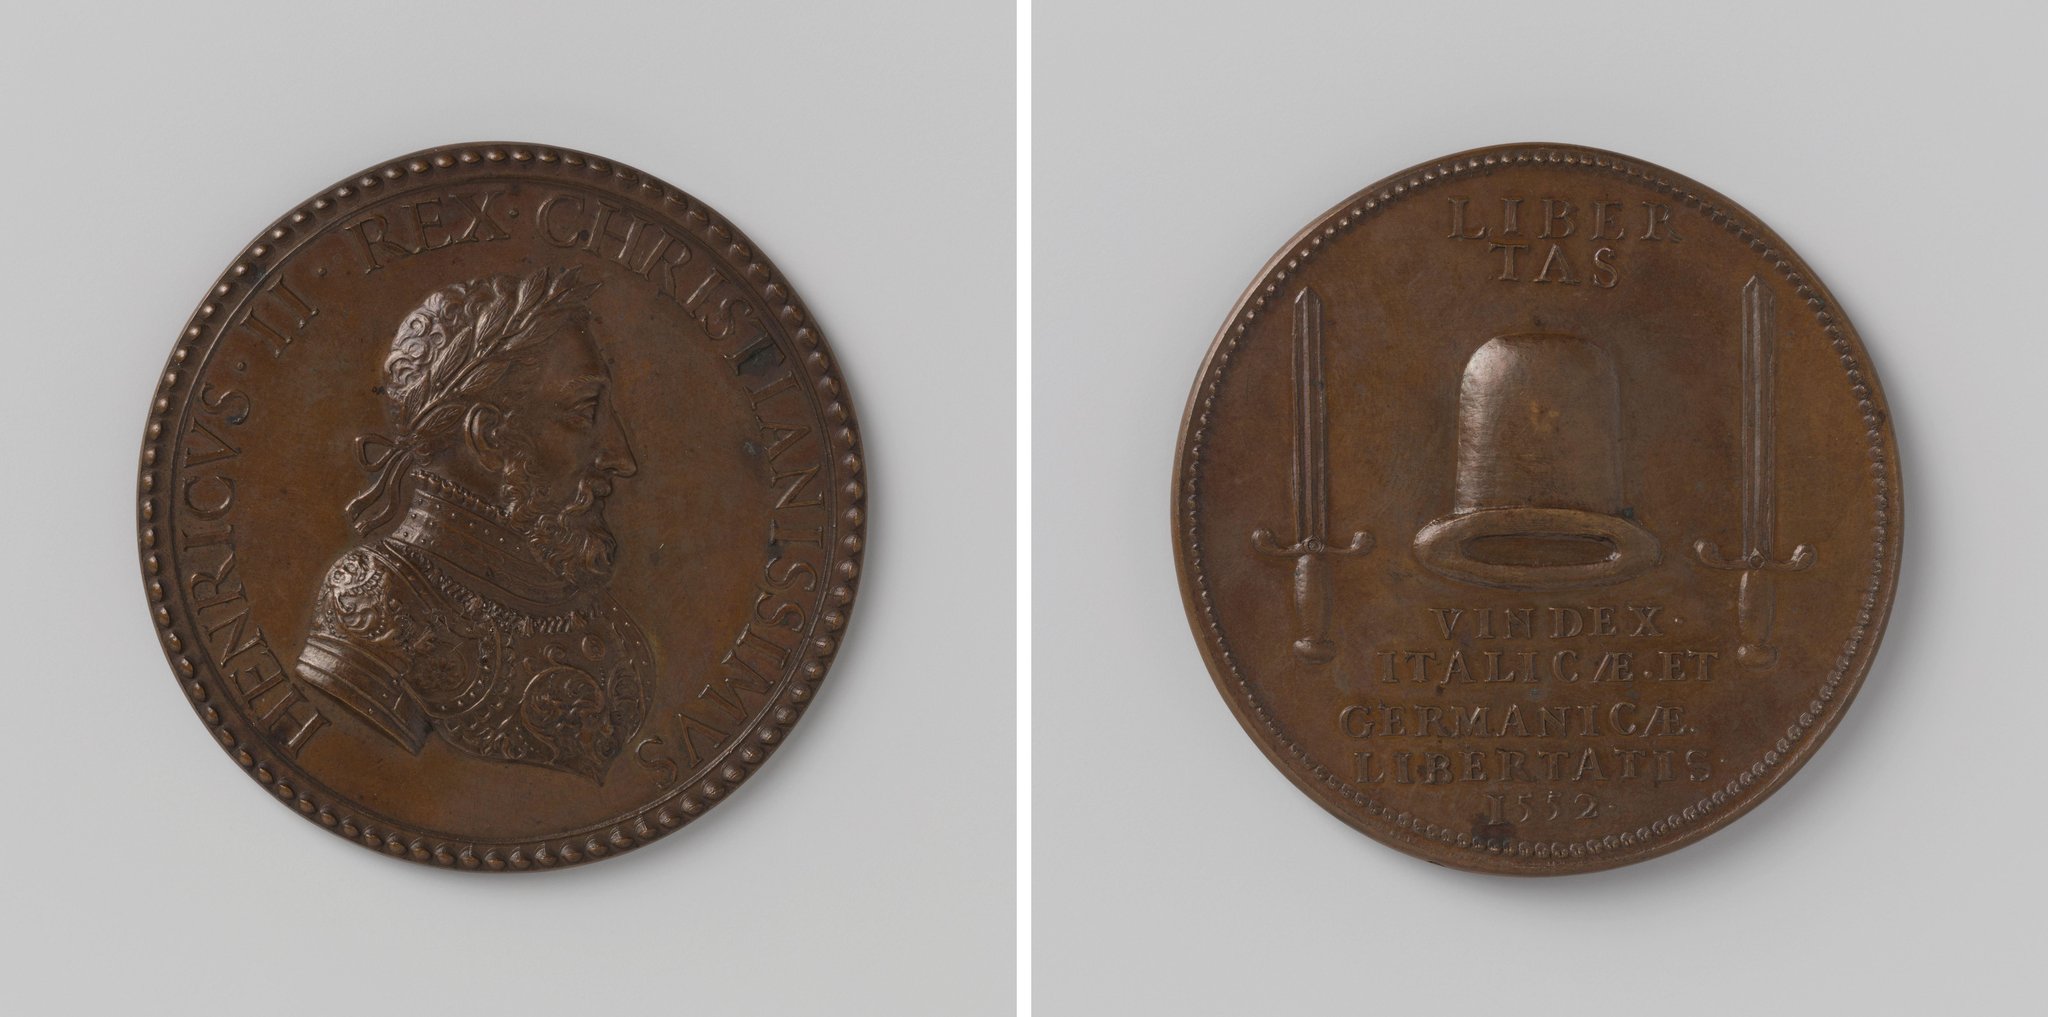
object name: history medal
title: Verdragen van Chambord en Friedewald tussen Hendrik II en de protestantse Duitse vorsten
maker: Anonymous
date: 1600-1650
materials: bronze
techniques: striking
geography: paris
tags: germany, treaty of chambord, treaty of friedewalde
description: Bronzen penning. Voorzijde: borststuk man binnen omschrift. Keerzijde: vrijheidshoed tussen twee dolken onder en boven opschrift.